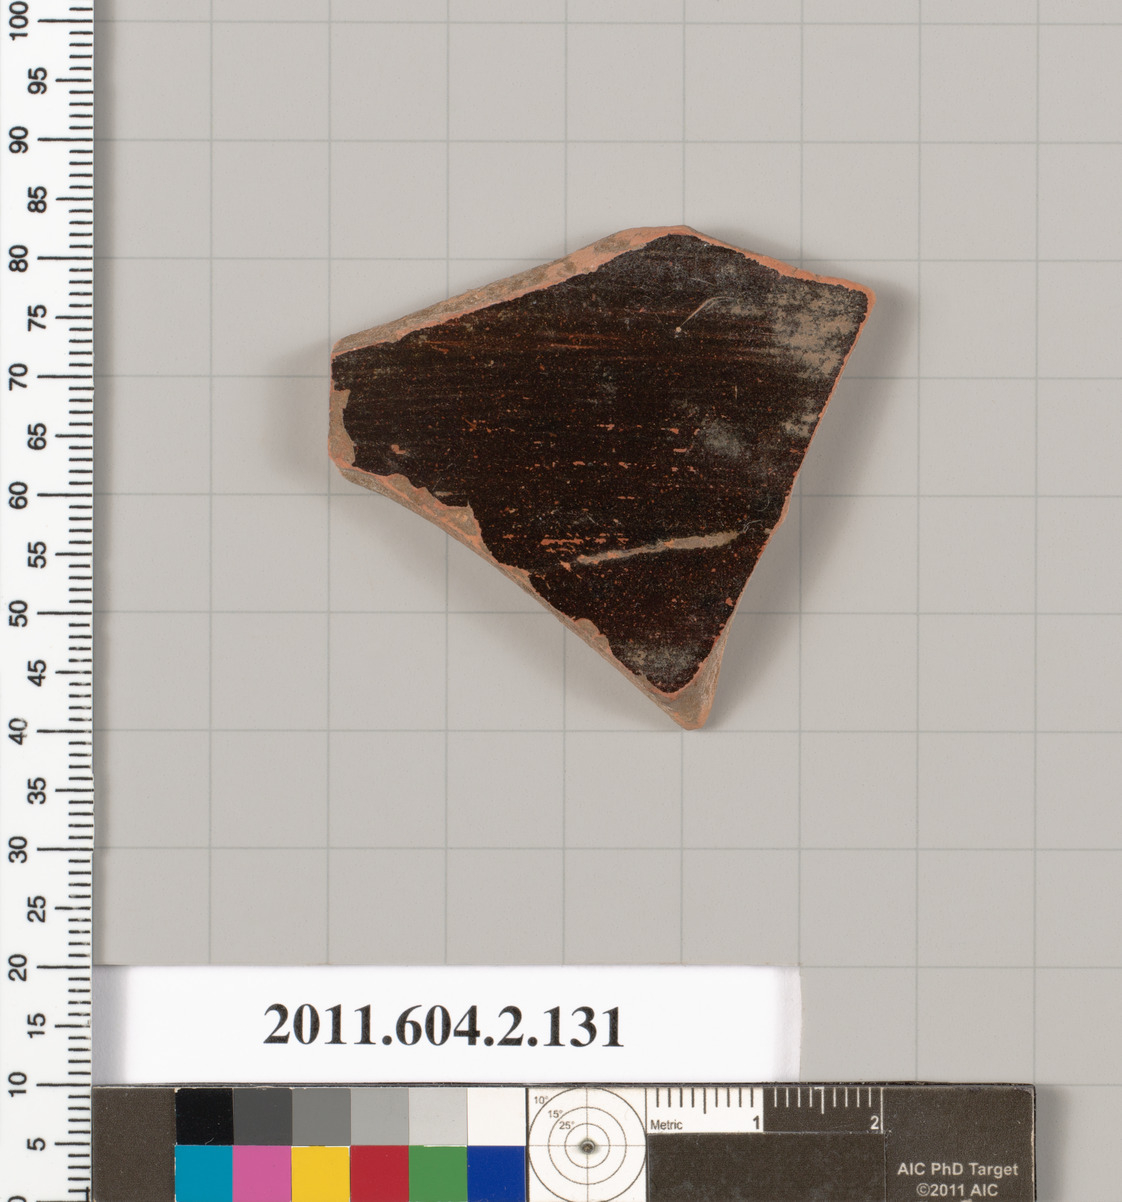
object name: pelike fragment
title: Terracotta fragment of a pelike (jar)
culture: greek, attic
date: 401-450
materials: terracotta